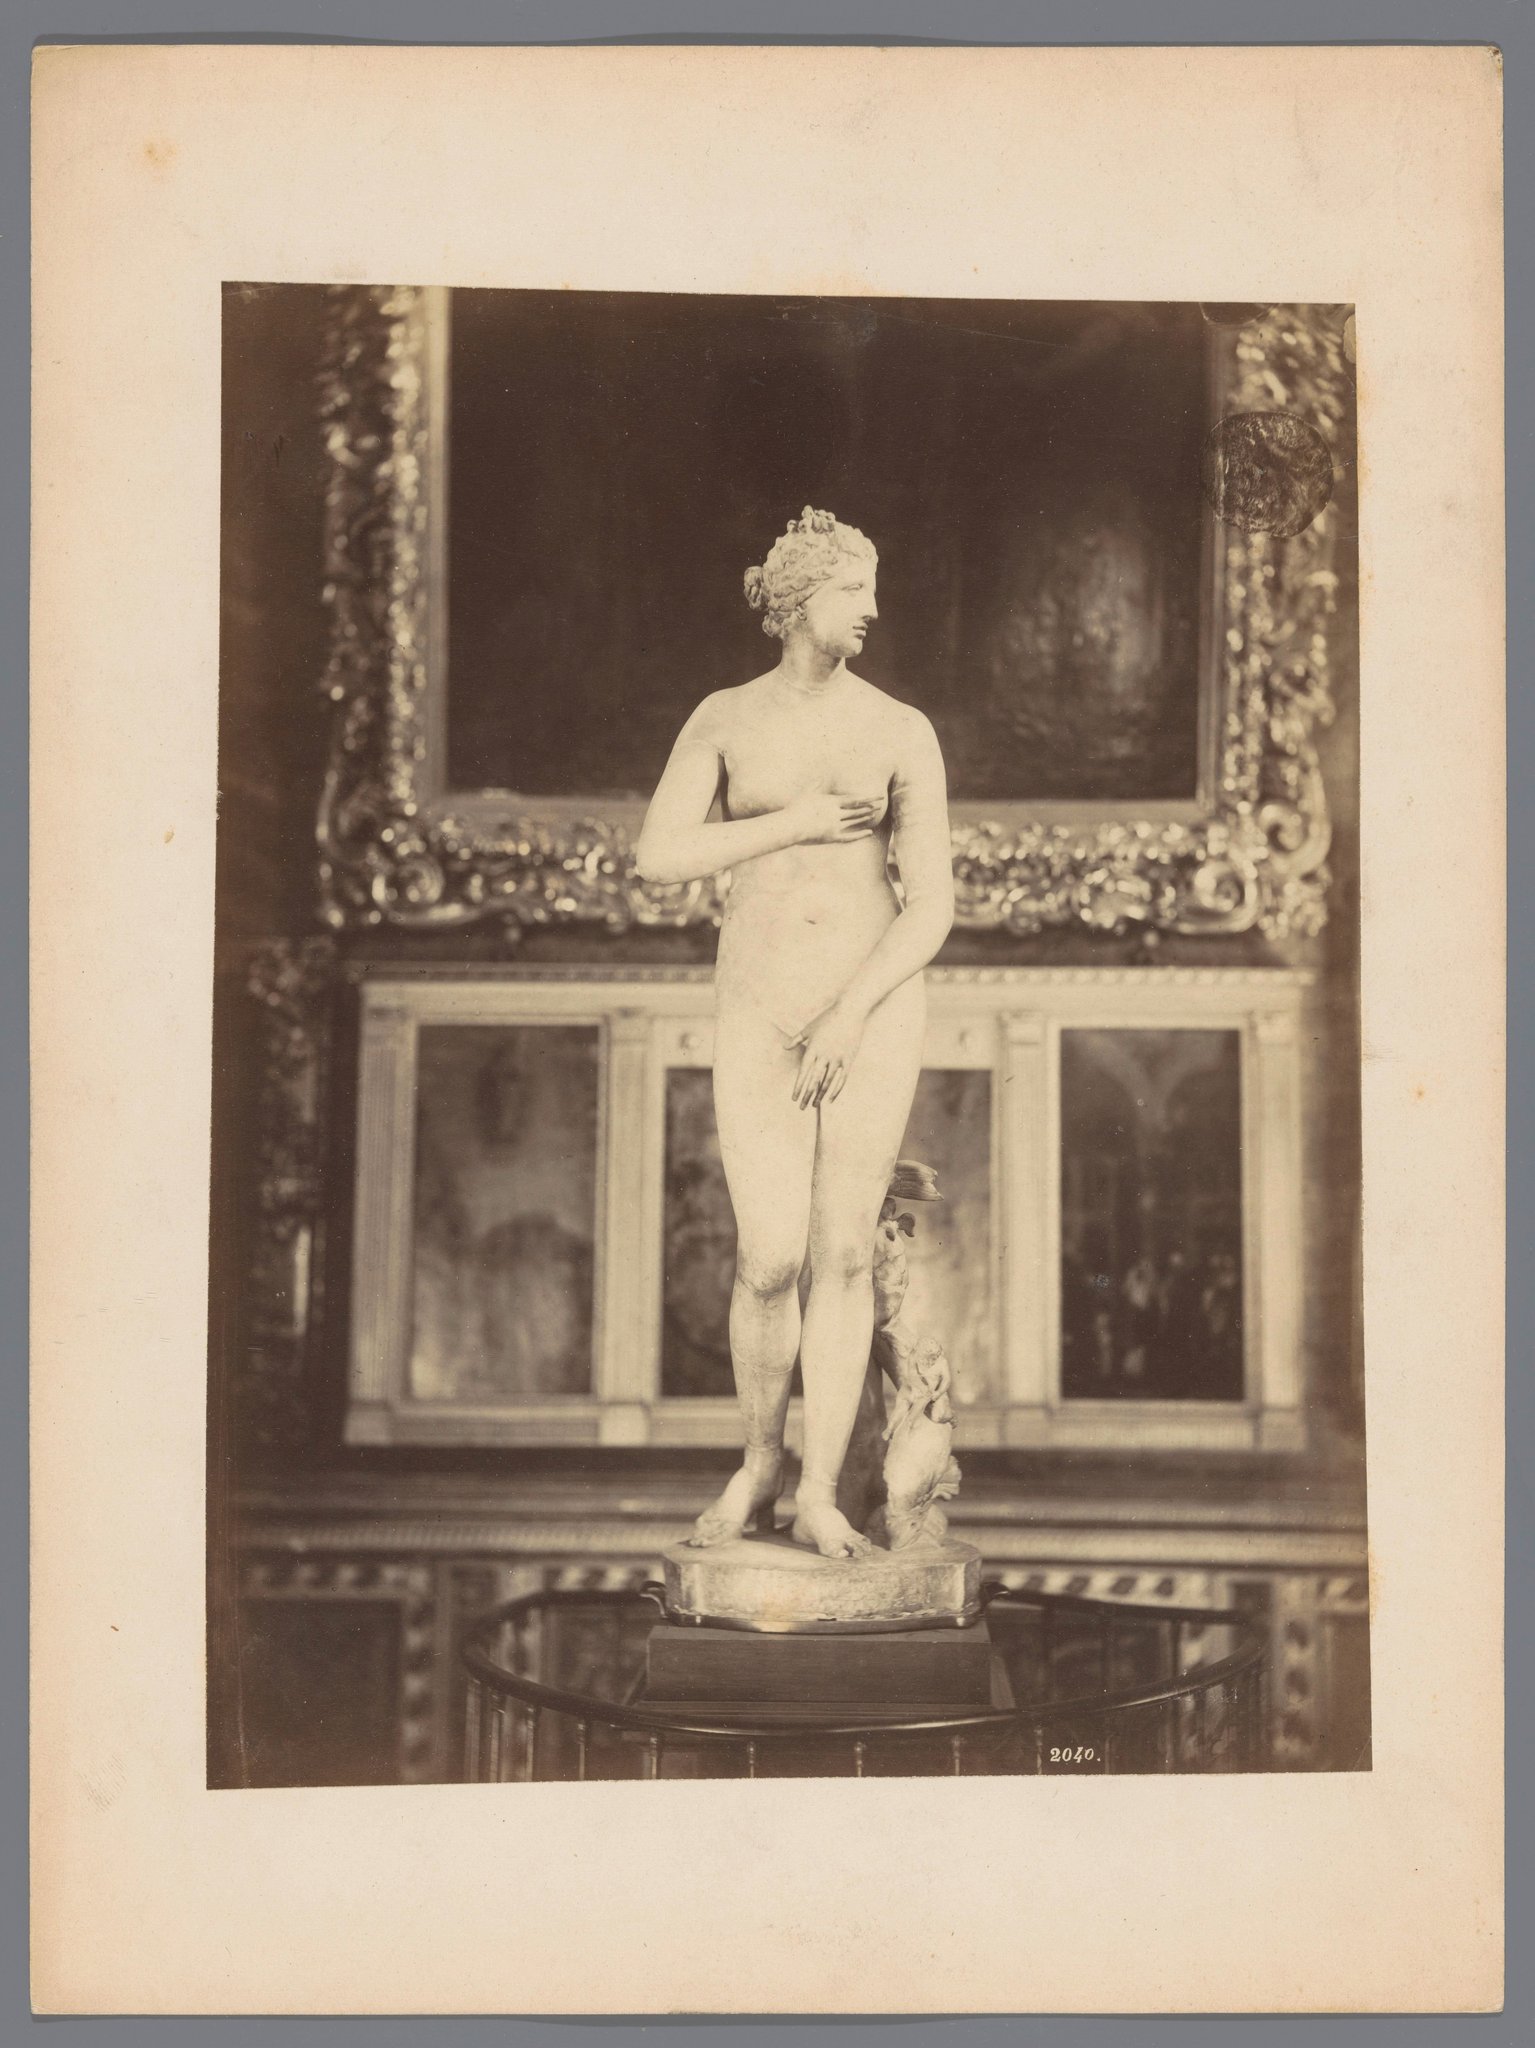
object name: photograph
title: Venus de' Medici in de Galleria degli Uffizi te Florence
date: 1875-1900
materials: photographic support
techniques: albumen print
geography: galleria degli uffizi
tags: (story of) venus (aphrodite), permanent exhibition, museum, sculpture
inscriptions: collector's mark: Lugt 3937, name: ‘Alinari’, number: ‘2040.’